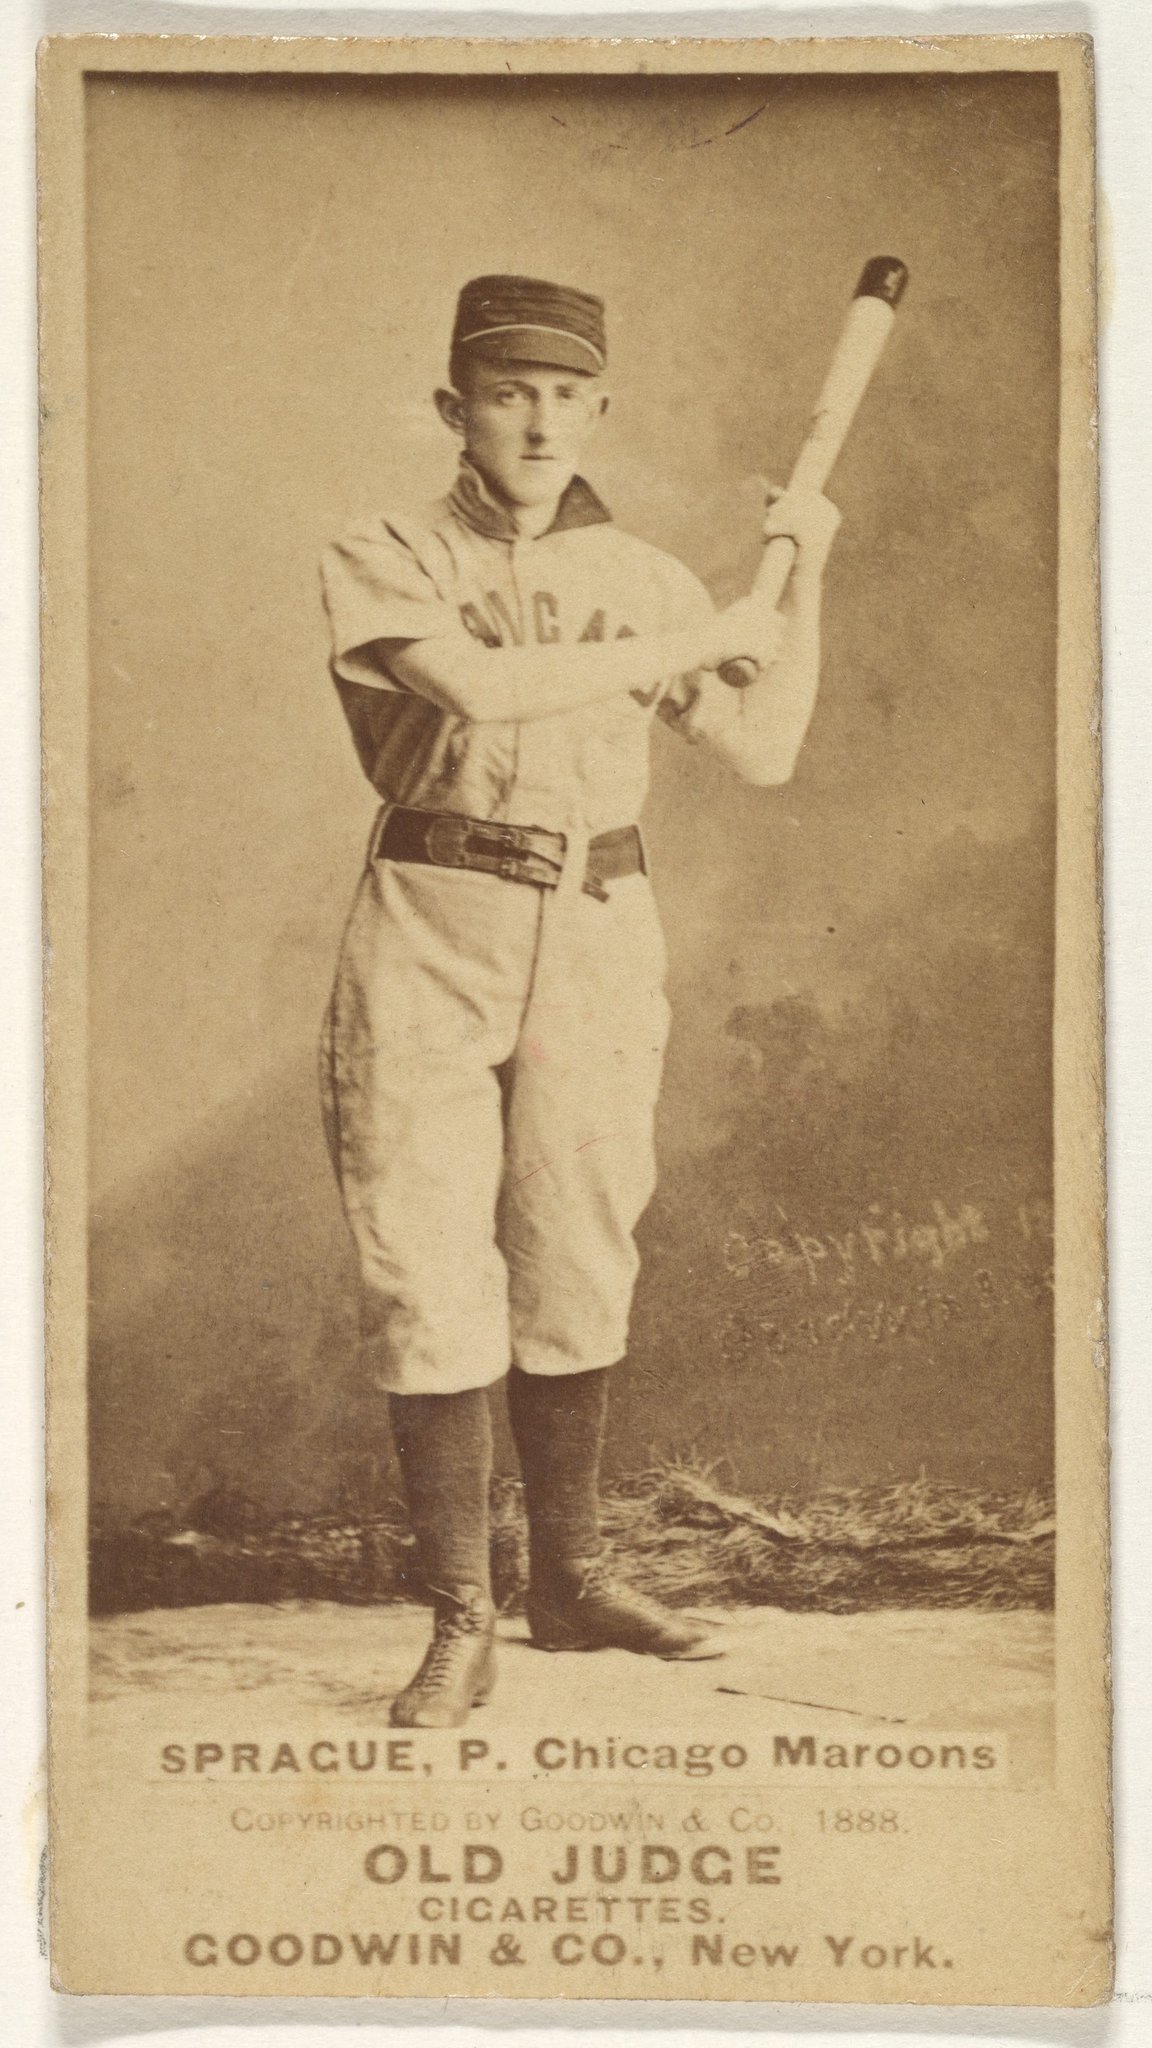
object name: baseball card, photograph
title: Sprague, Pitcher, Chicago, from the Old Judge series (N172) for Old Judge Cigarettes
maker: goodwin & company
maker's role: publisher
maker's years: 1850-1950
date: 1888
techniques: albumen silver print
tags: men,portraits,baseball,athletes